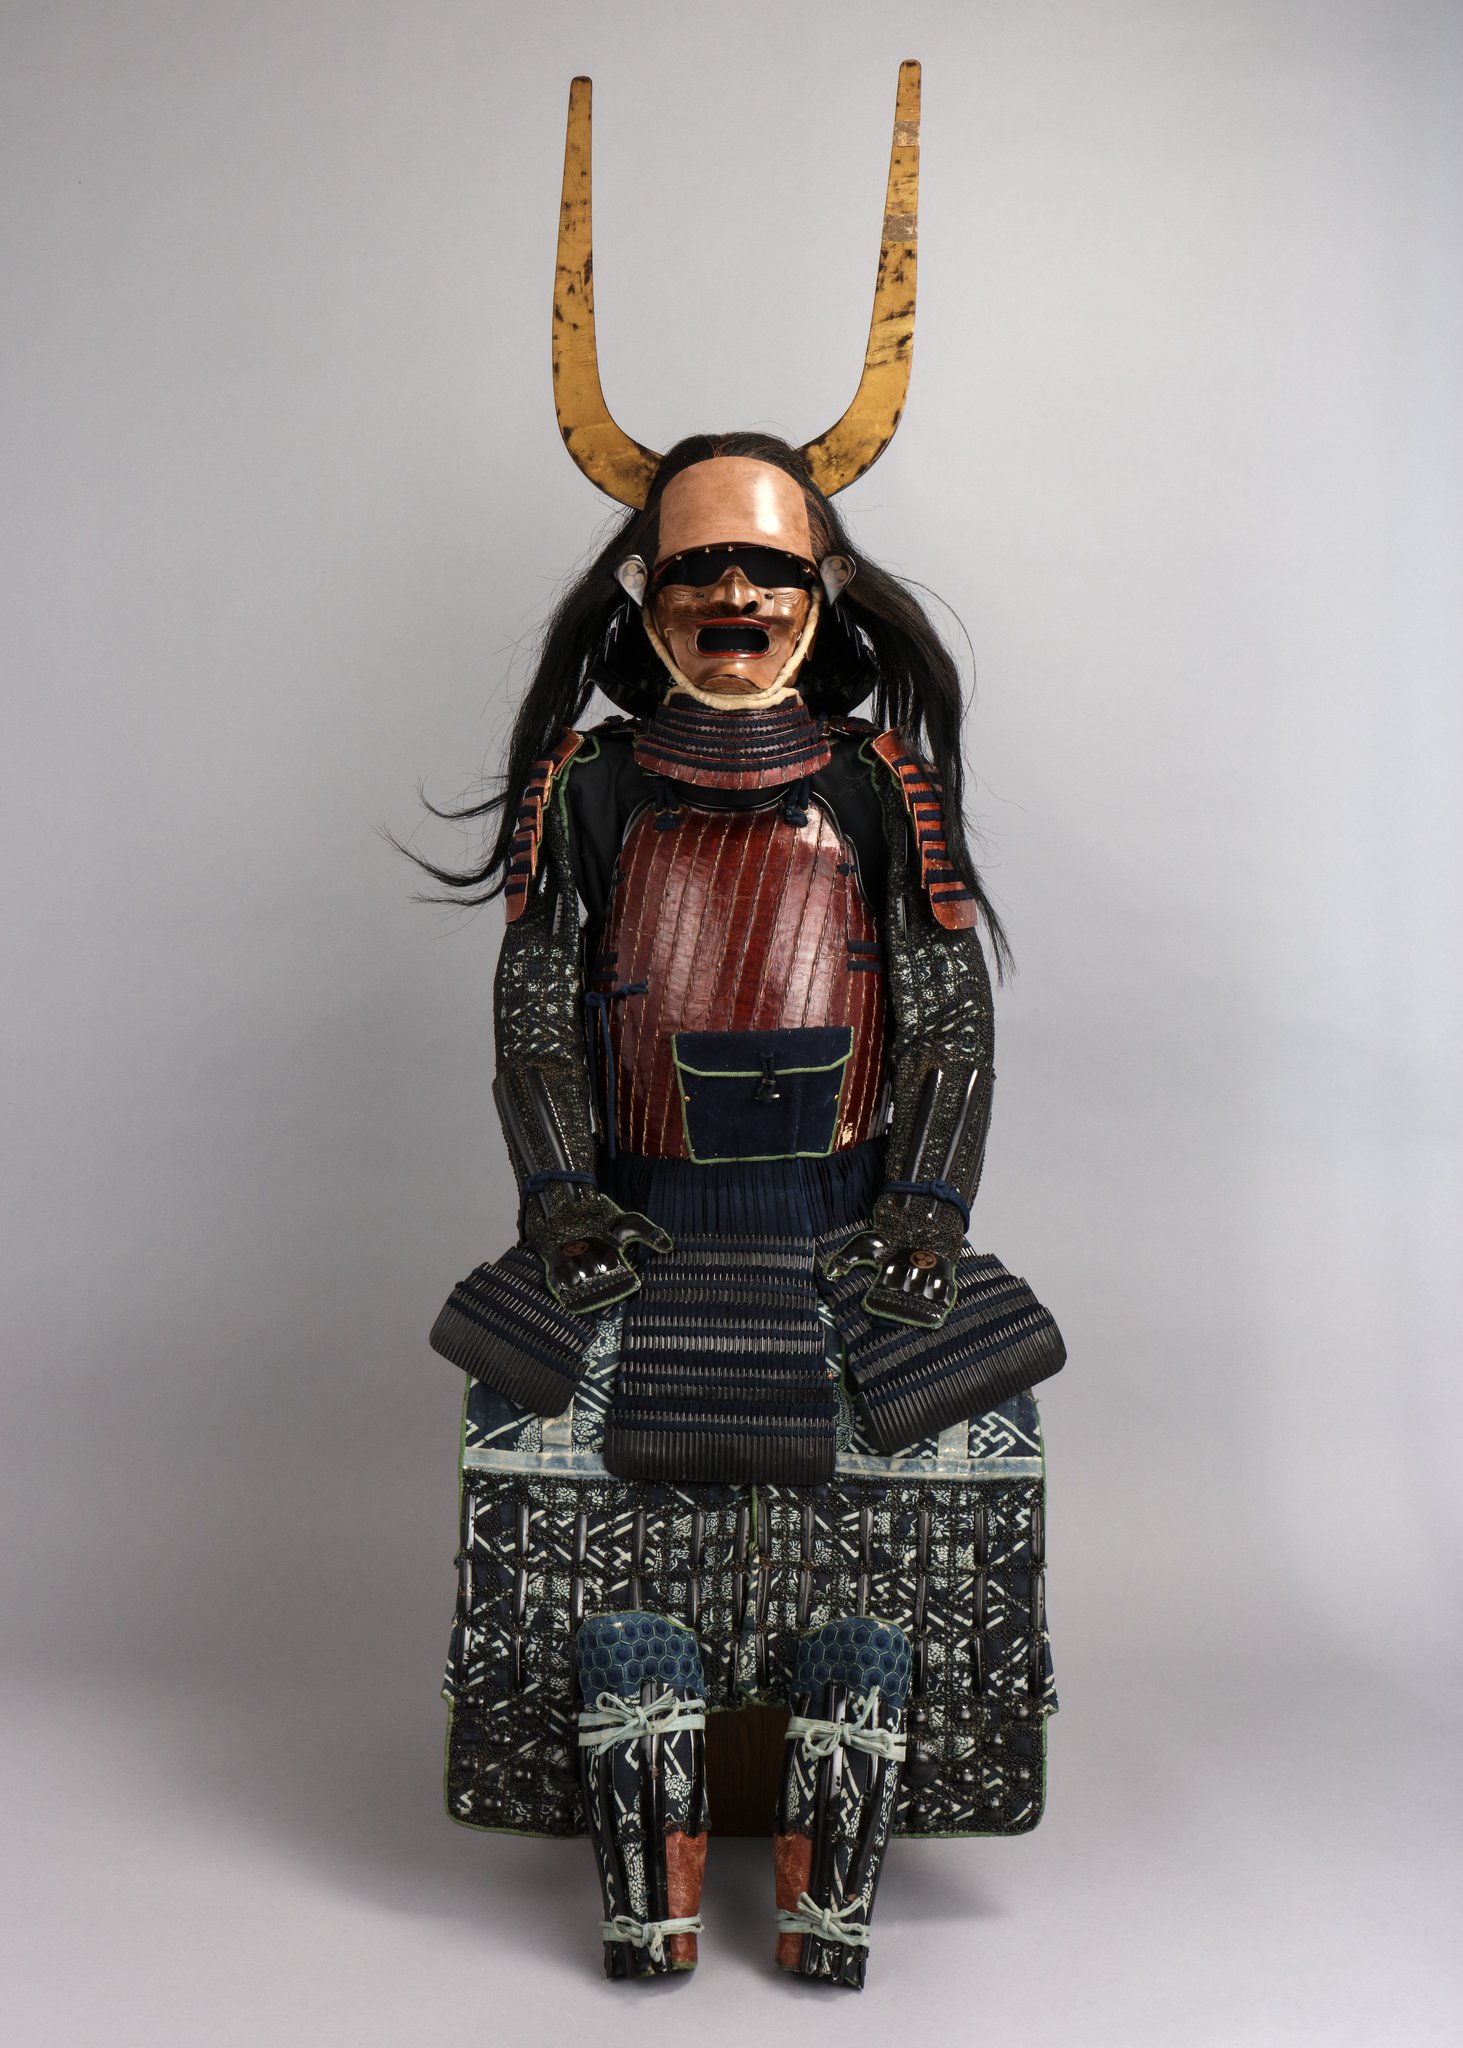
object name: armor i nimai dō gusoku i with box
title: Armor (Nimai-Dō Gusoku) with Box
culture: japanese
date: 1567-1633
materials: hair, hemp, iron, lacquer, leather, textile, wood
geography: japan